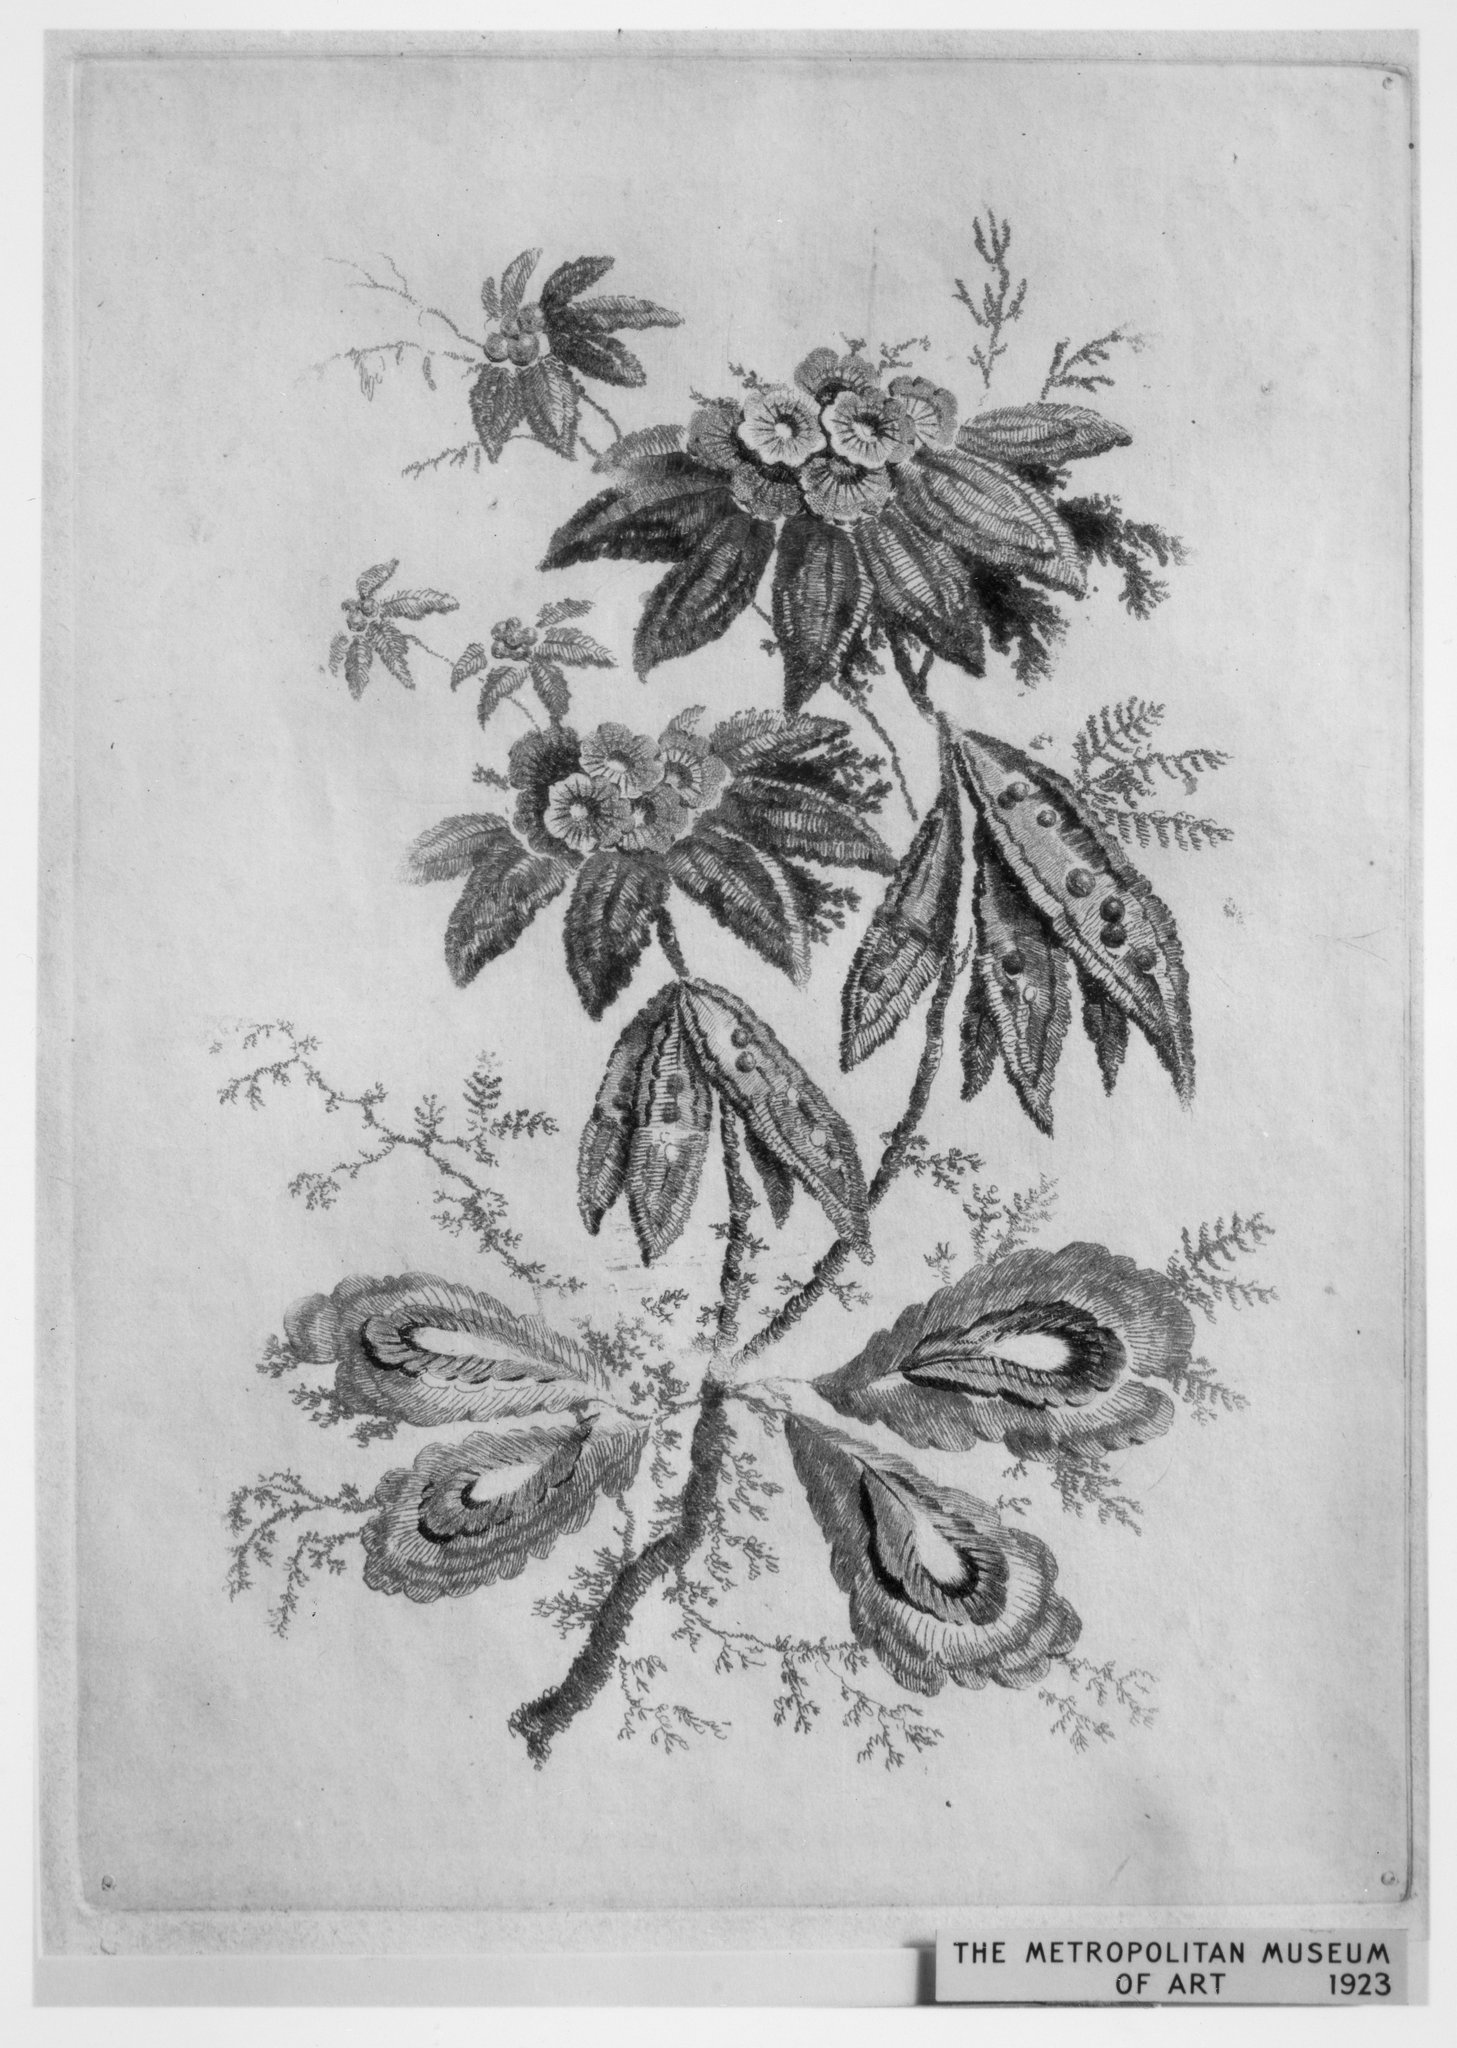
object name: print ornament architecture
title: Flowers, from "Nouvelle Suite de Cahiers de Fleurs idéales a l'usage des dessinateurs et des peintres" (Nr 3)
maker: jean pillement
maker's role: artist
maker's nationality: french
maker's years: 1728-1808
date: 1790-1799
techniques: etching, lithography